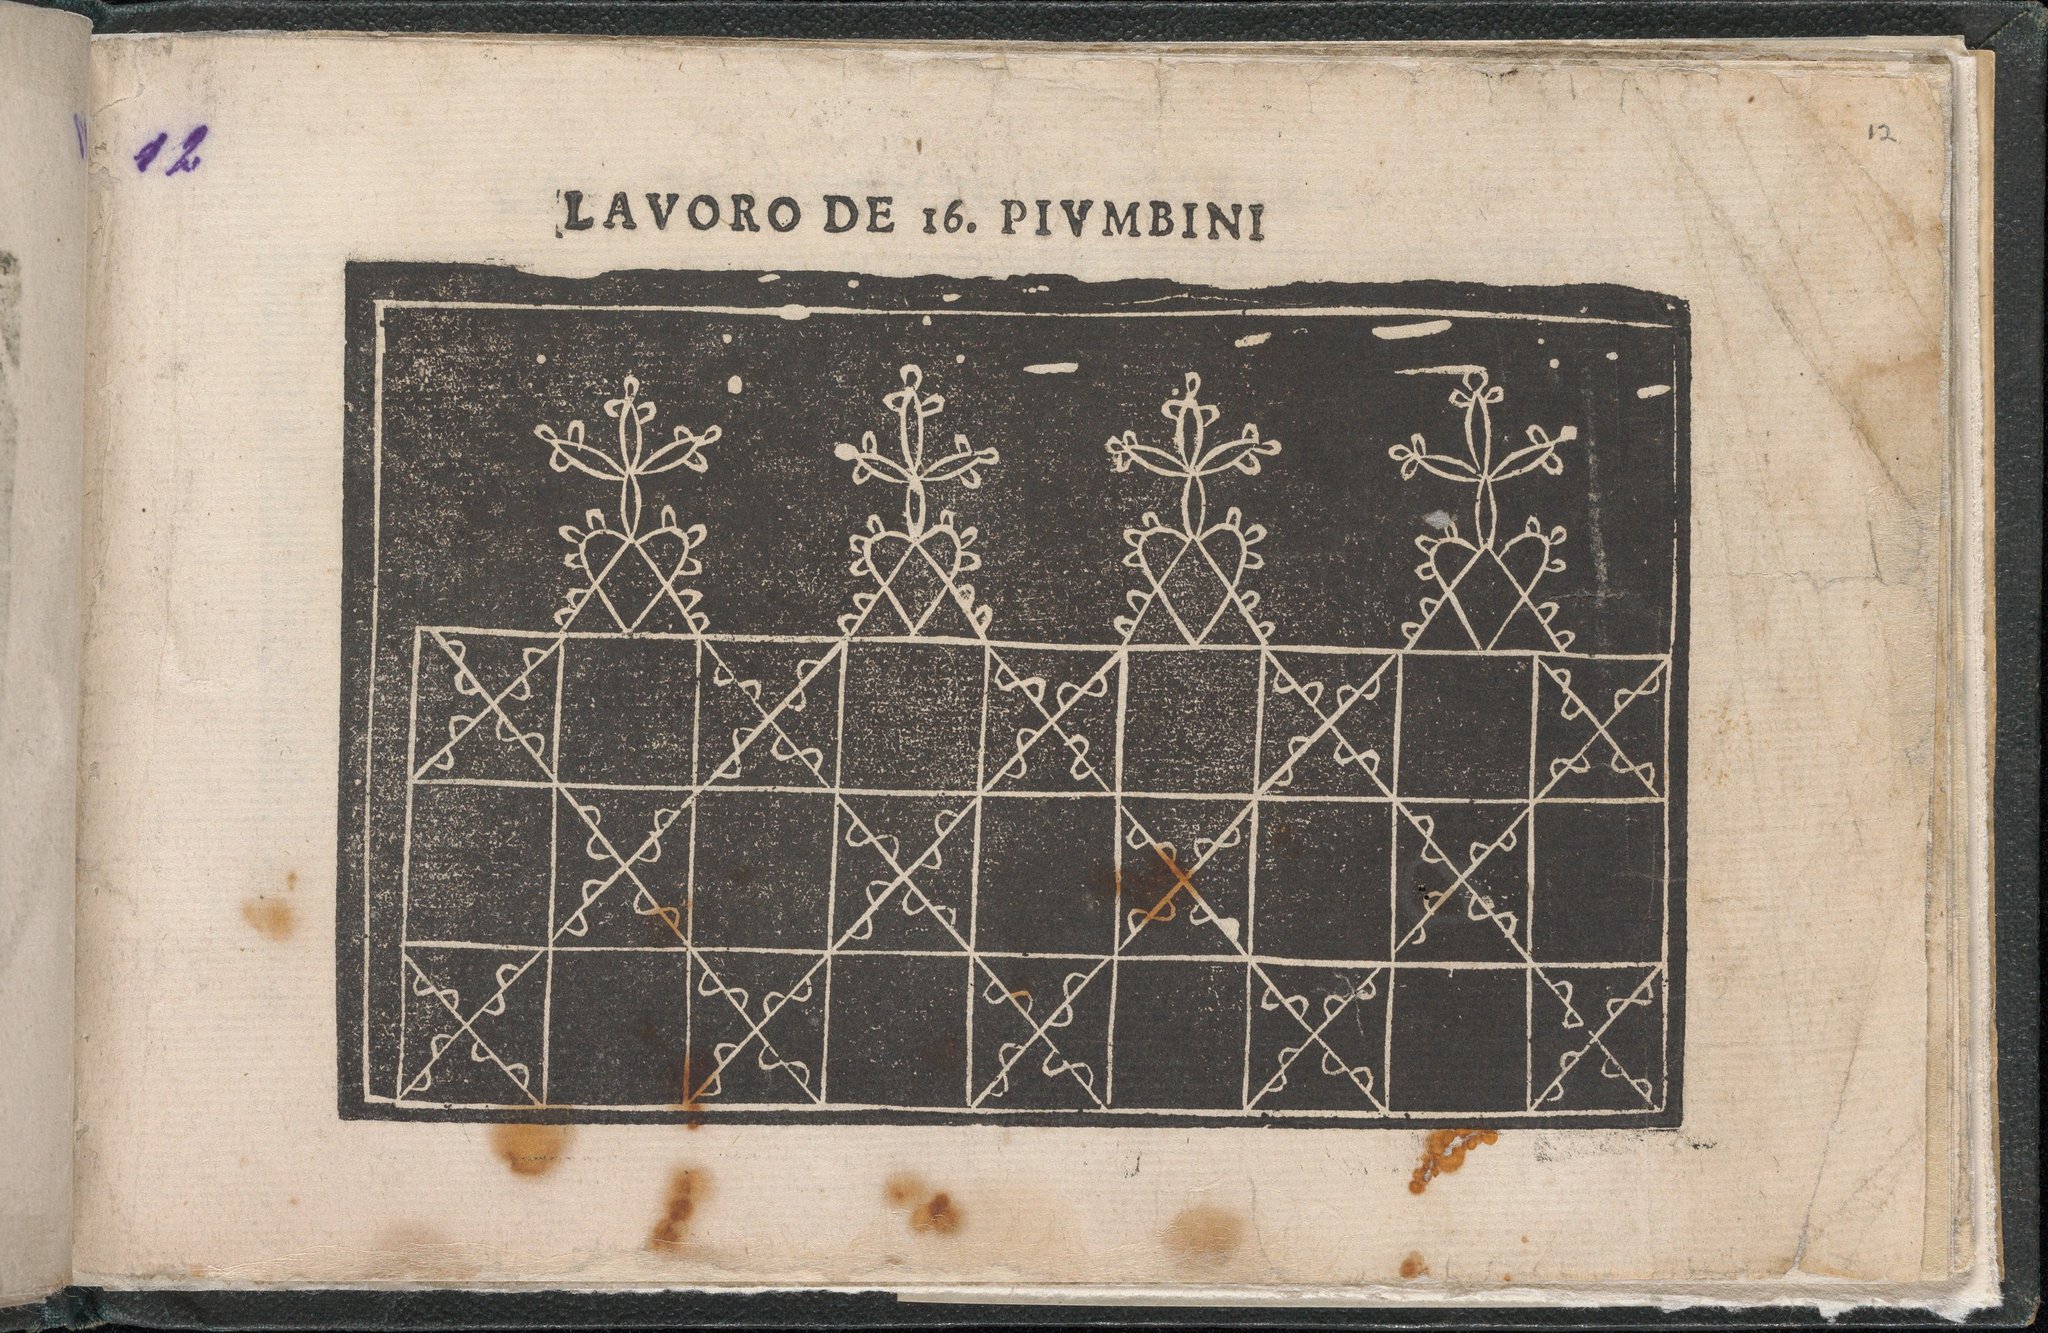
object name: book print ornament architecture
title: Gemma pretiosa della virtuose donne, page 12 (recto)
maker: isabella catanea parasole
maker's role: designer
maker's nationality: italian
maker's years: 1565-1625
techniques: woodcut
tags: ornament